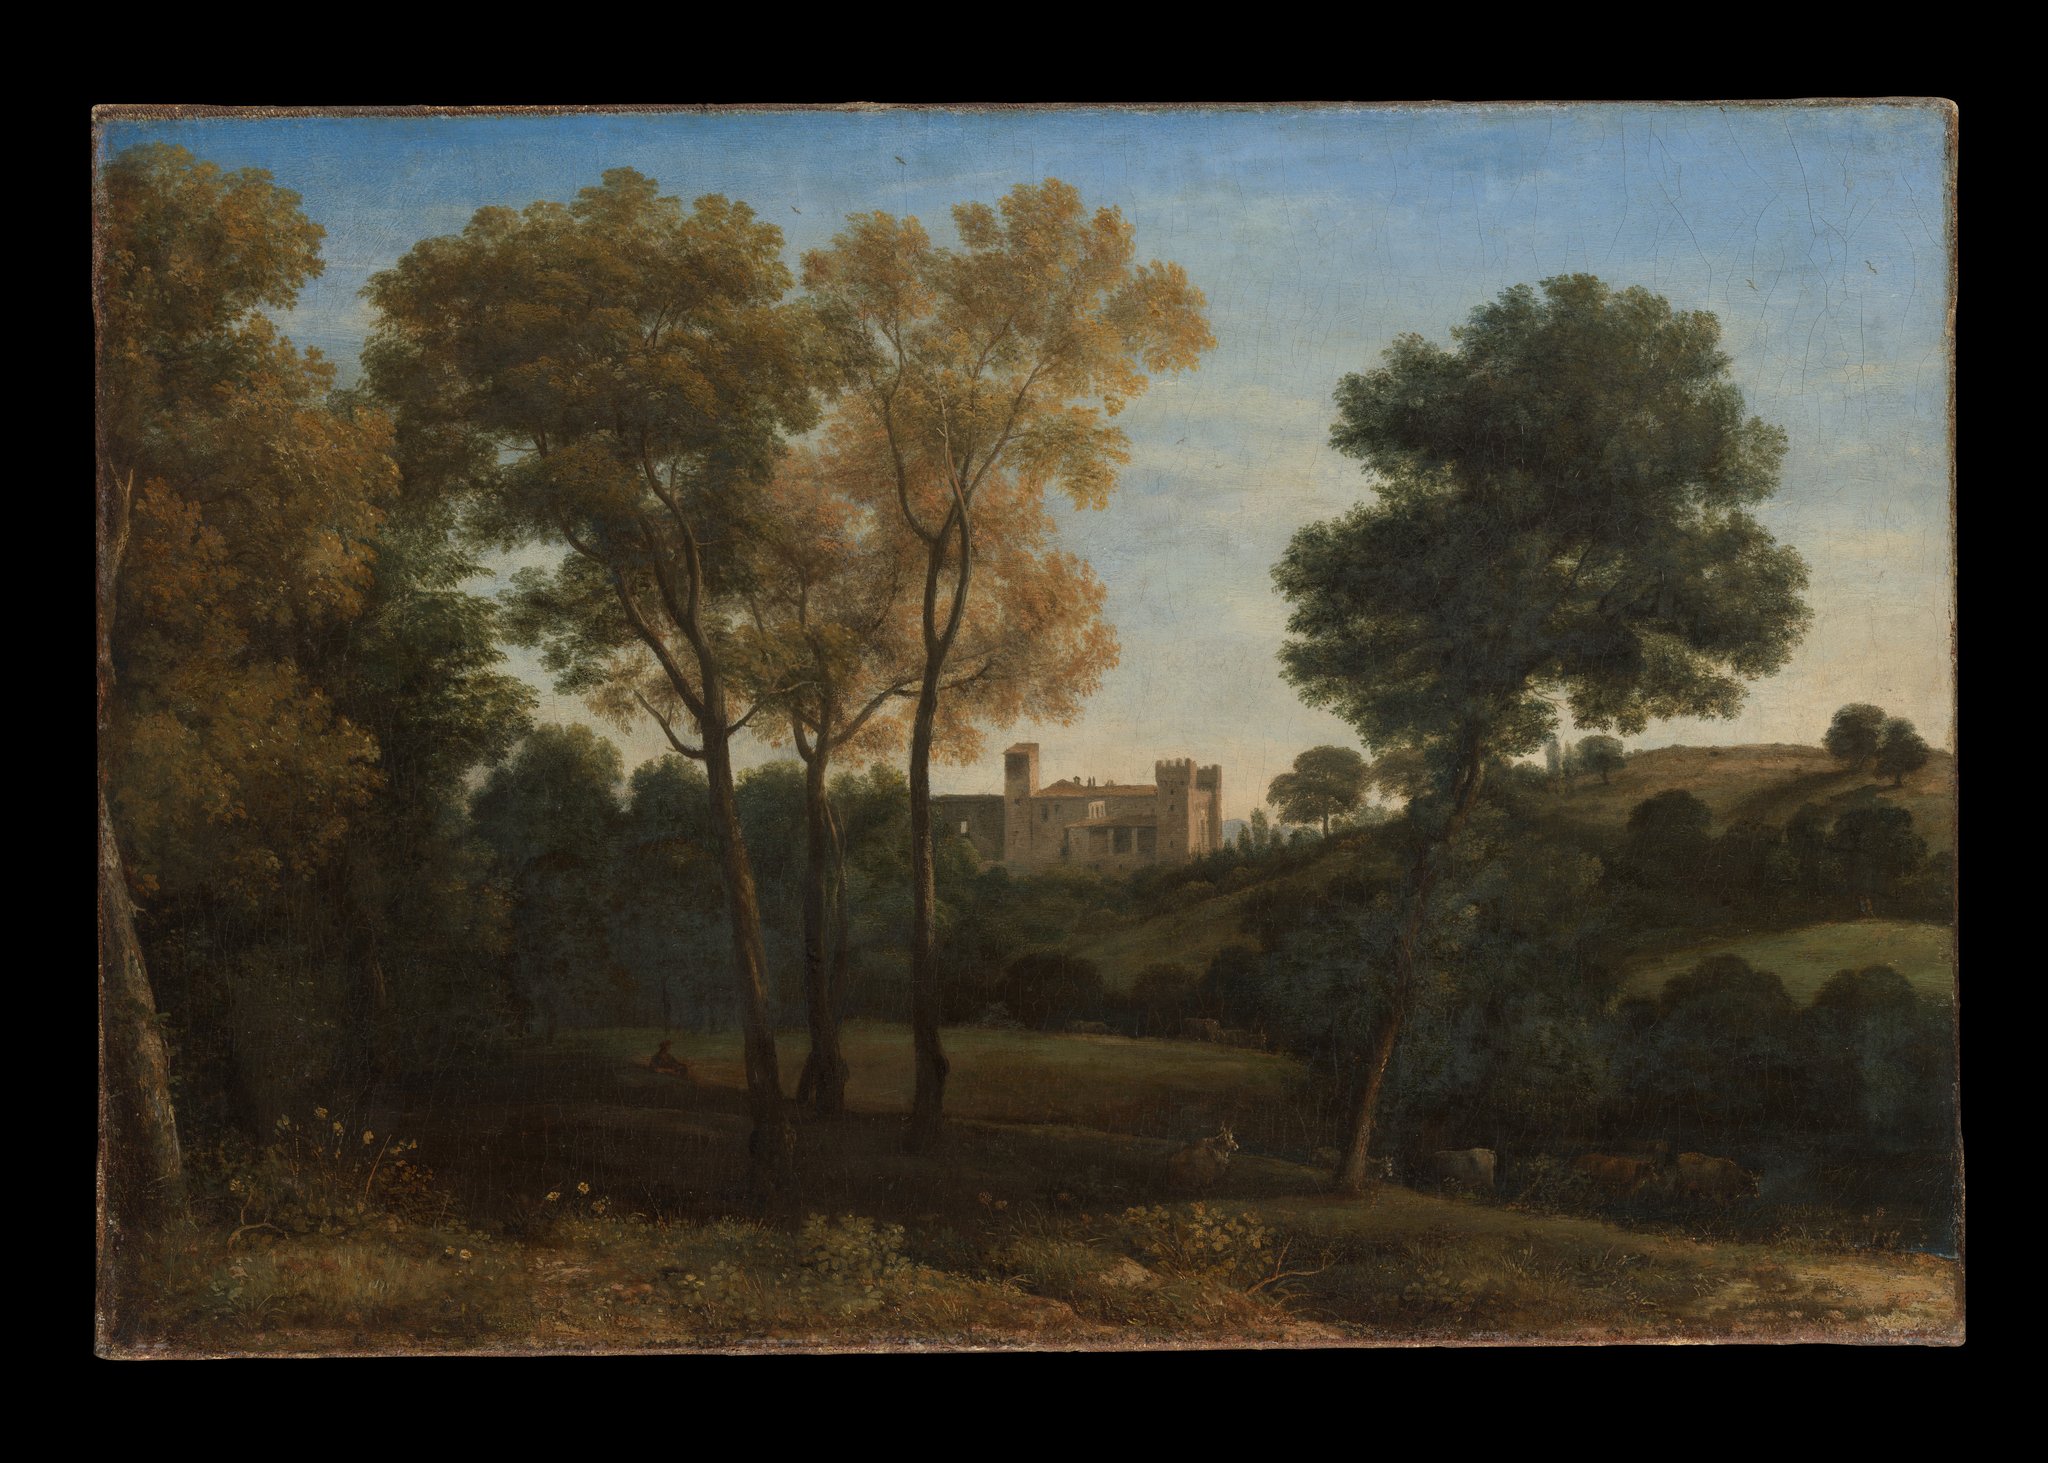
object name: painting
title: View of La Crescenza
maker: claude lorrain (claude gellée)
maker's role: artist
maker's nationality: french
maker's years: 1604-1682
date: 1648-1650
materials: canvas, oil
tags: landscapes